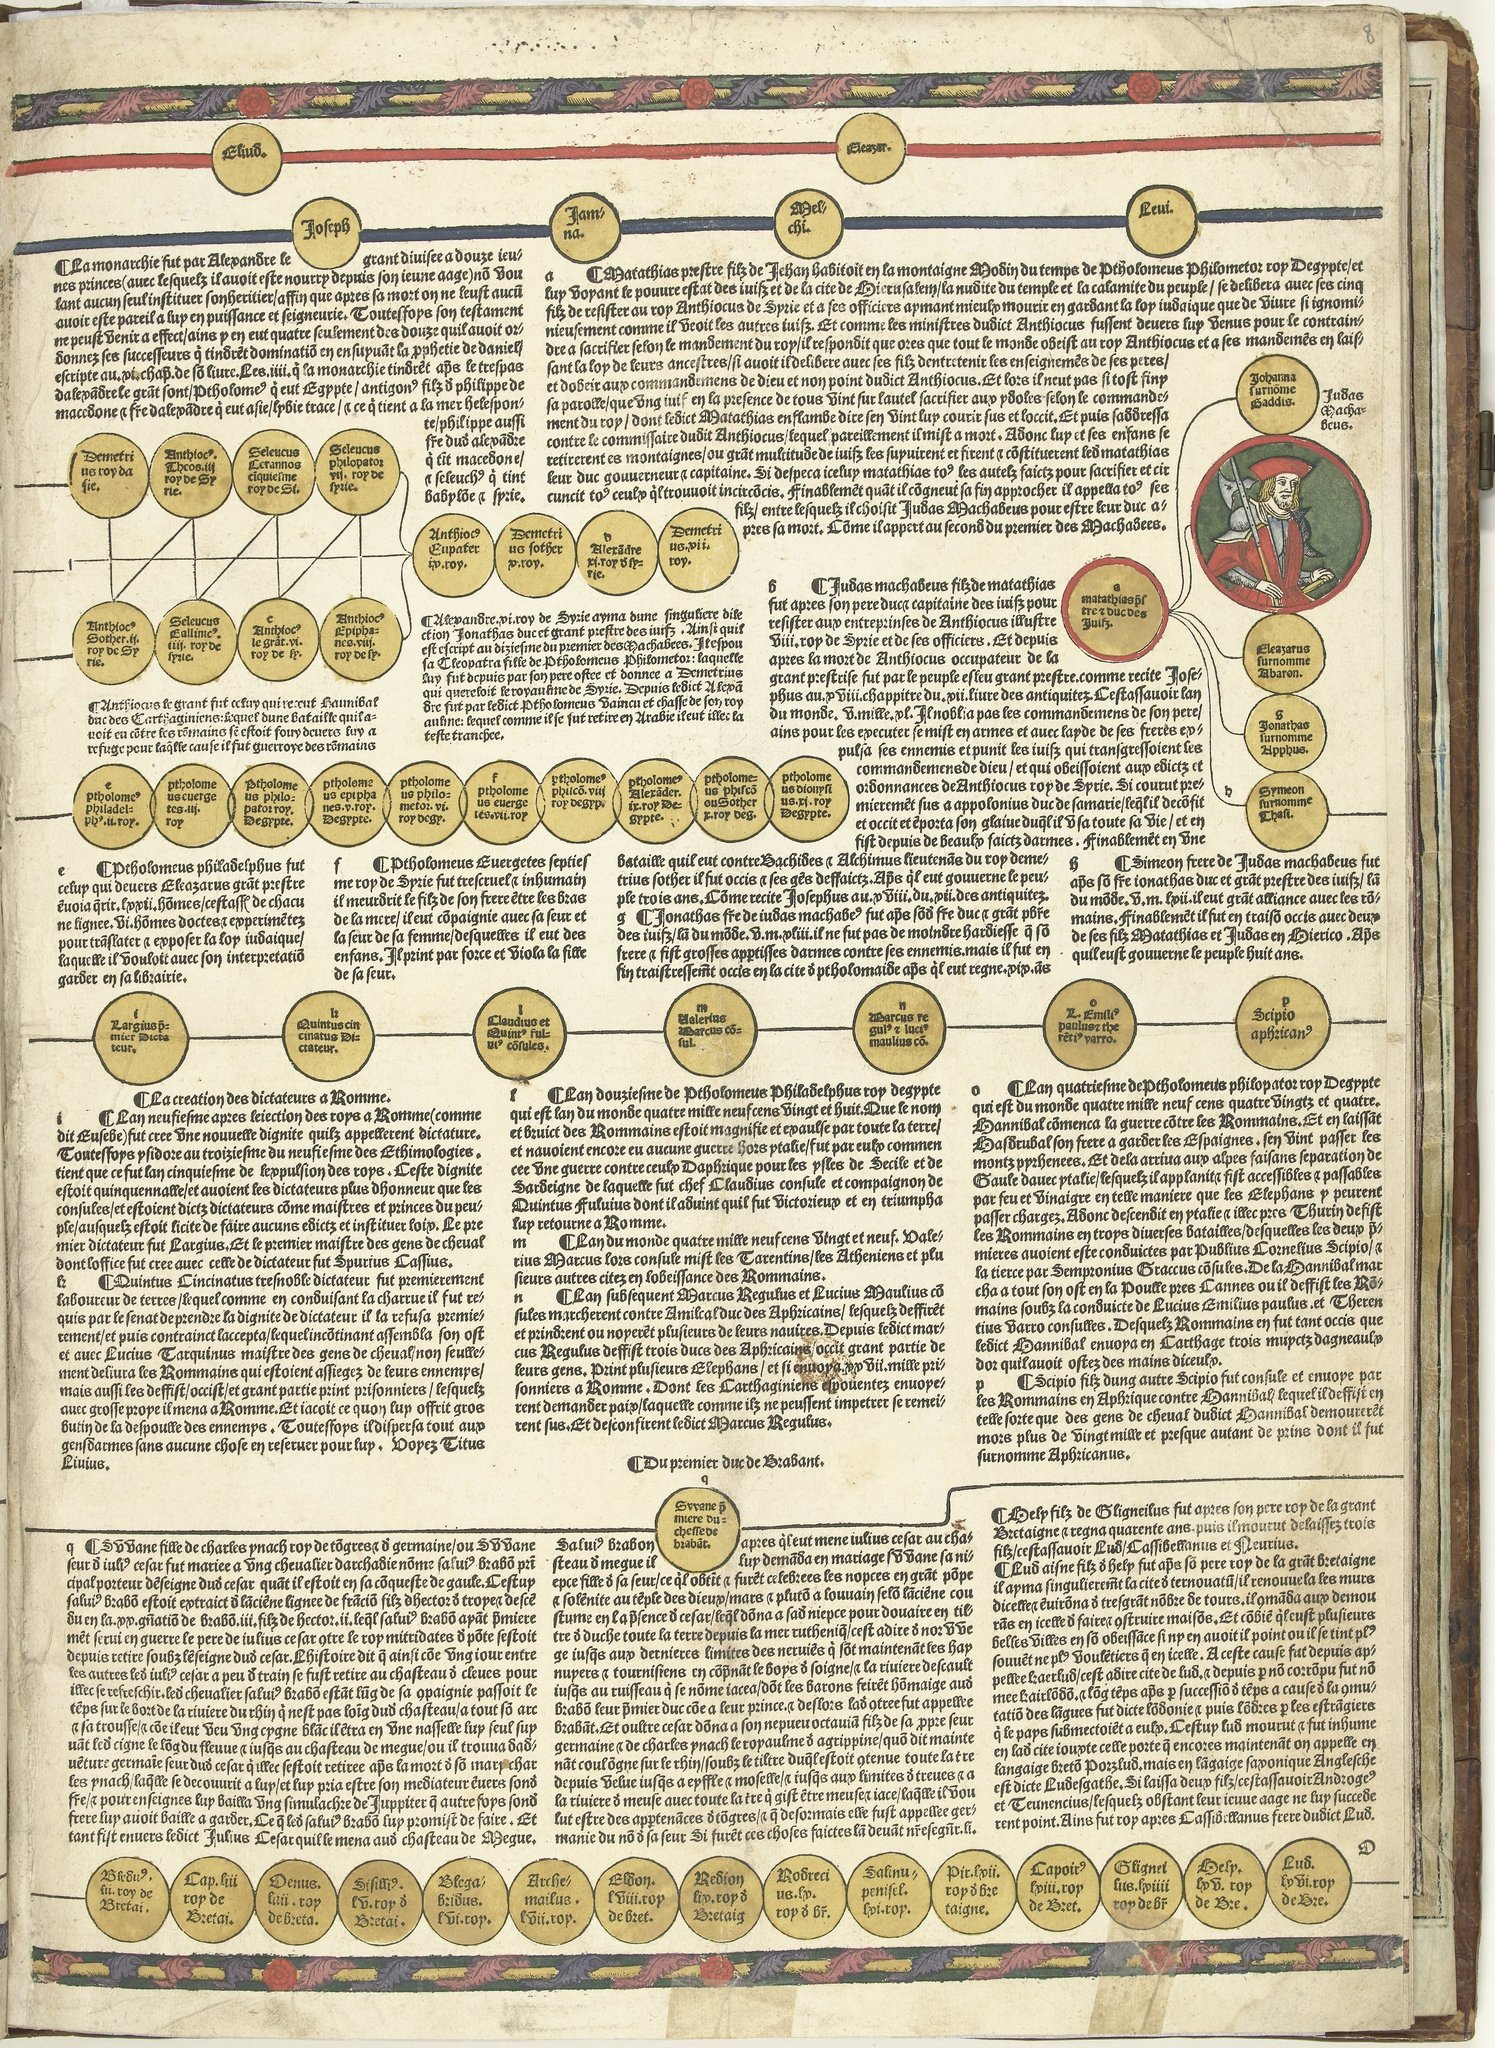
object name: album leaf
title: Cronica Cronicarum (...), blad 8 recto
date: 1521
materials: paper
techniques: letterpress printing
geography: paris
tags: judas maccabeus (not in biblical context)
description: Blad 8 recto van een wereldkroniek. Tekst in boekdruk in het Frans. Rechtsboven een ronde voorstelling van Judas de Makkabeeër. De ronde voorstelling is verbonden met andere cirkels die gevuld zijn met namen: deze vormen samen een schematische weergave van genealogie en vorstenopvolging, die zich uitstrekt over meerdere bladzijden van de kroniek.